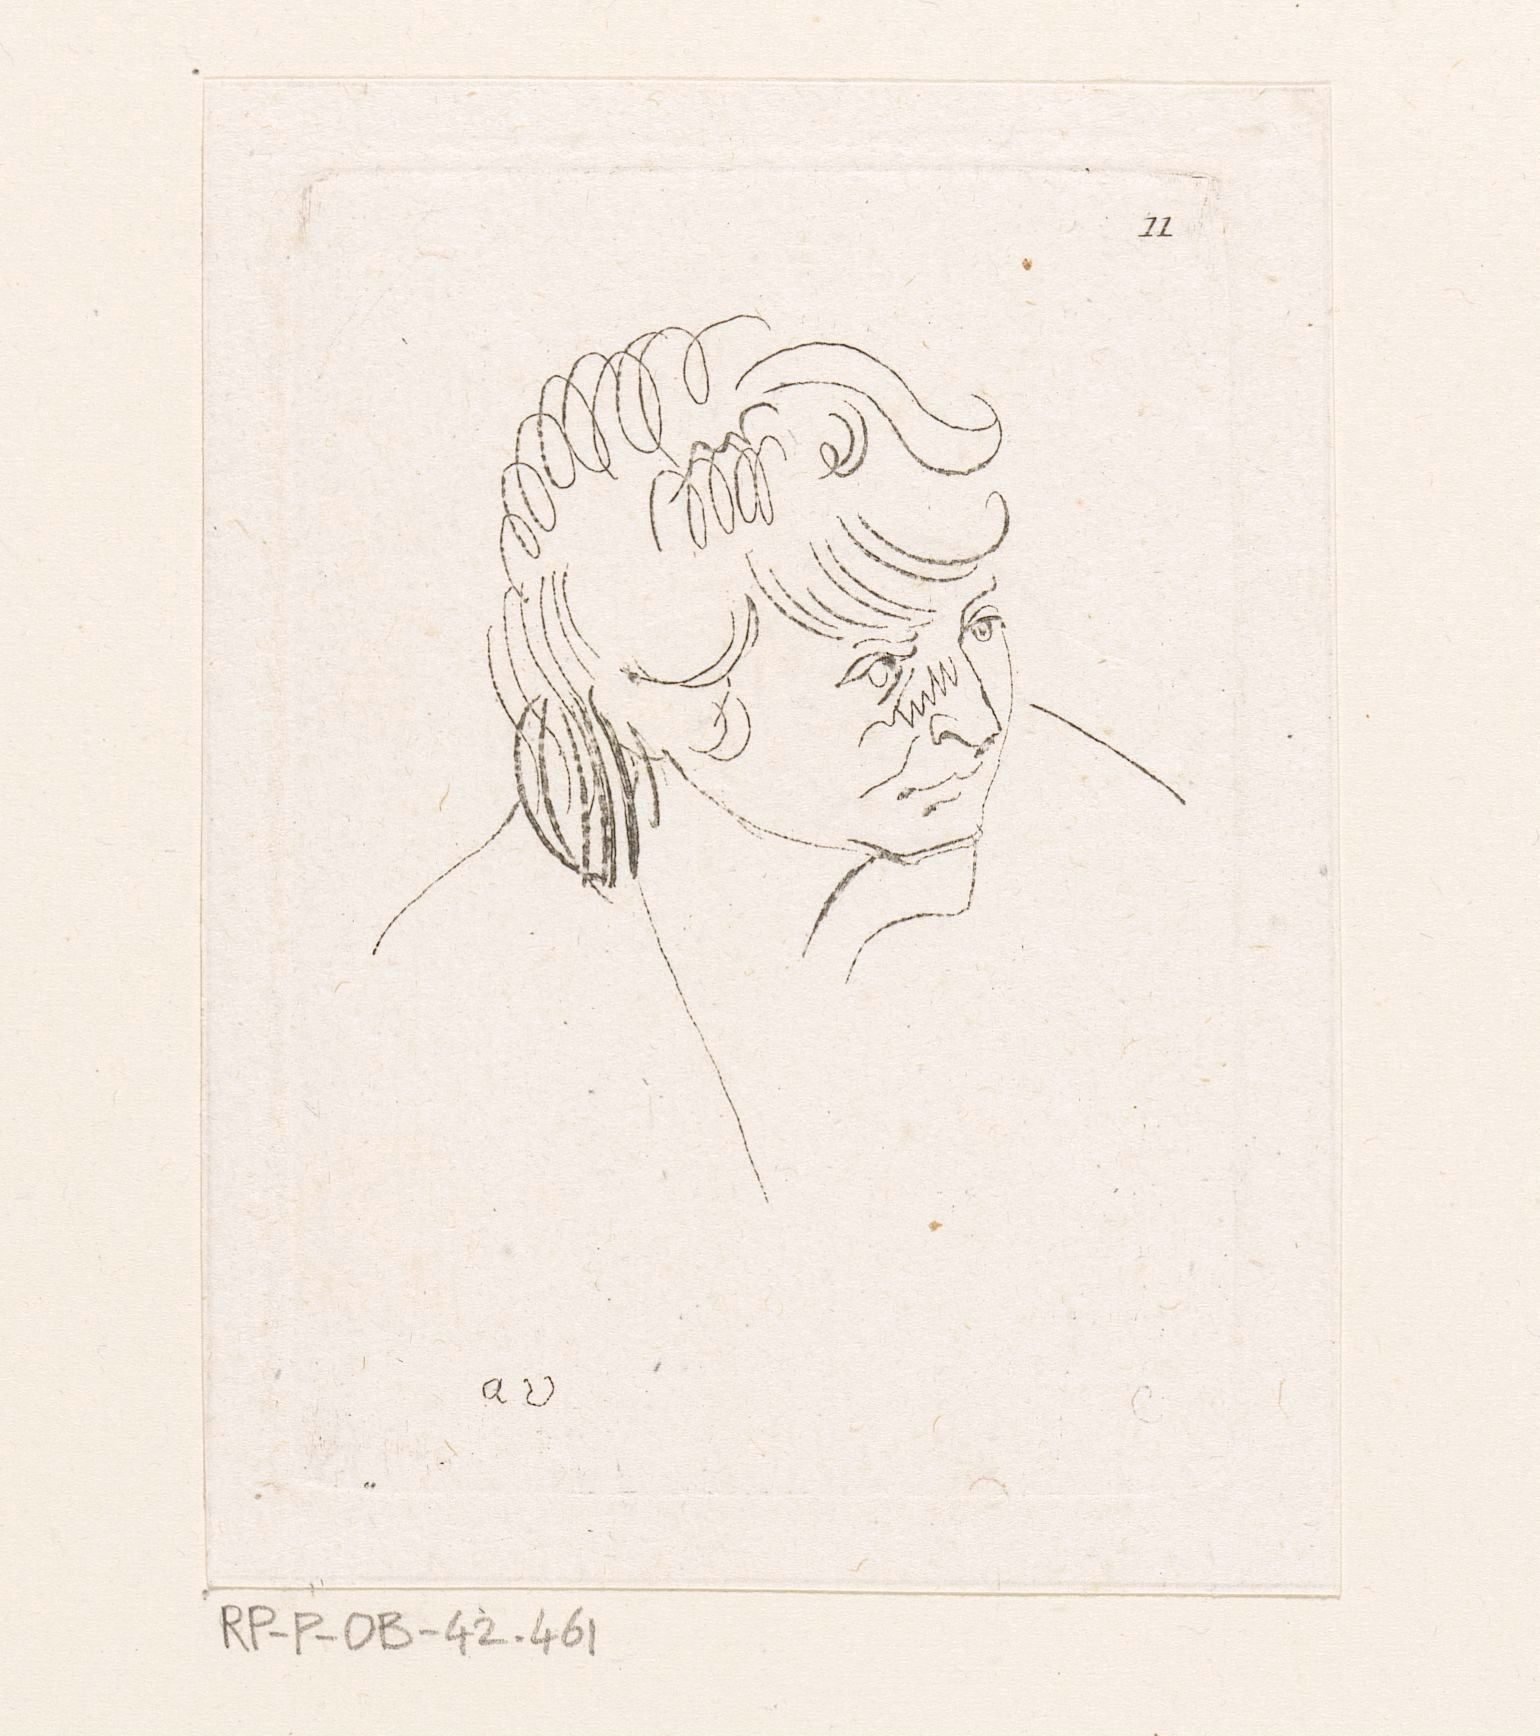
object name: print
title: Hoofd van een jongeman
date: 1735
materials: paper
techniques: etching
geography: france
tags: head (human), youth, adolescent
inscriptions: collector's mark: Lugt 240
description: Prent uit een serie van 31 prenten naar getekende hoofden door Van Dyck, plus een titelprent naar Bouchardon, getiteld: "Recueil de Testes d'Antoine Van Dyck tirées du Cabinet de M. Crozat et gravées par M. le C. de C.".